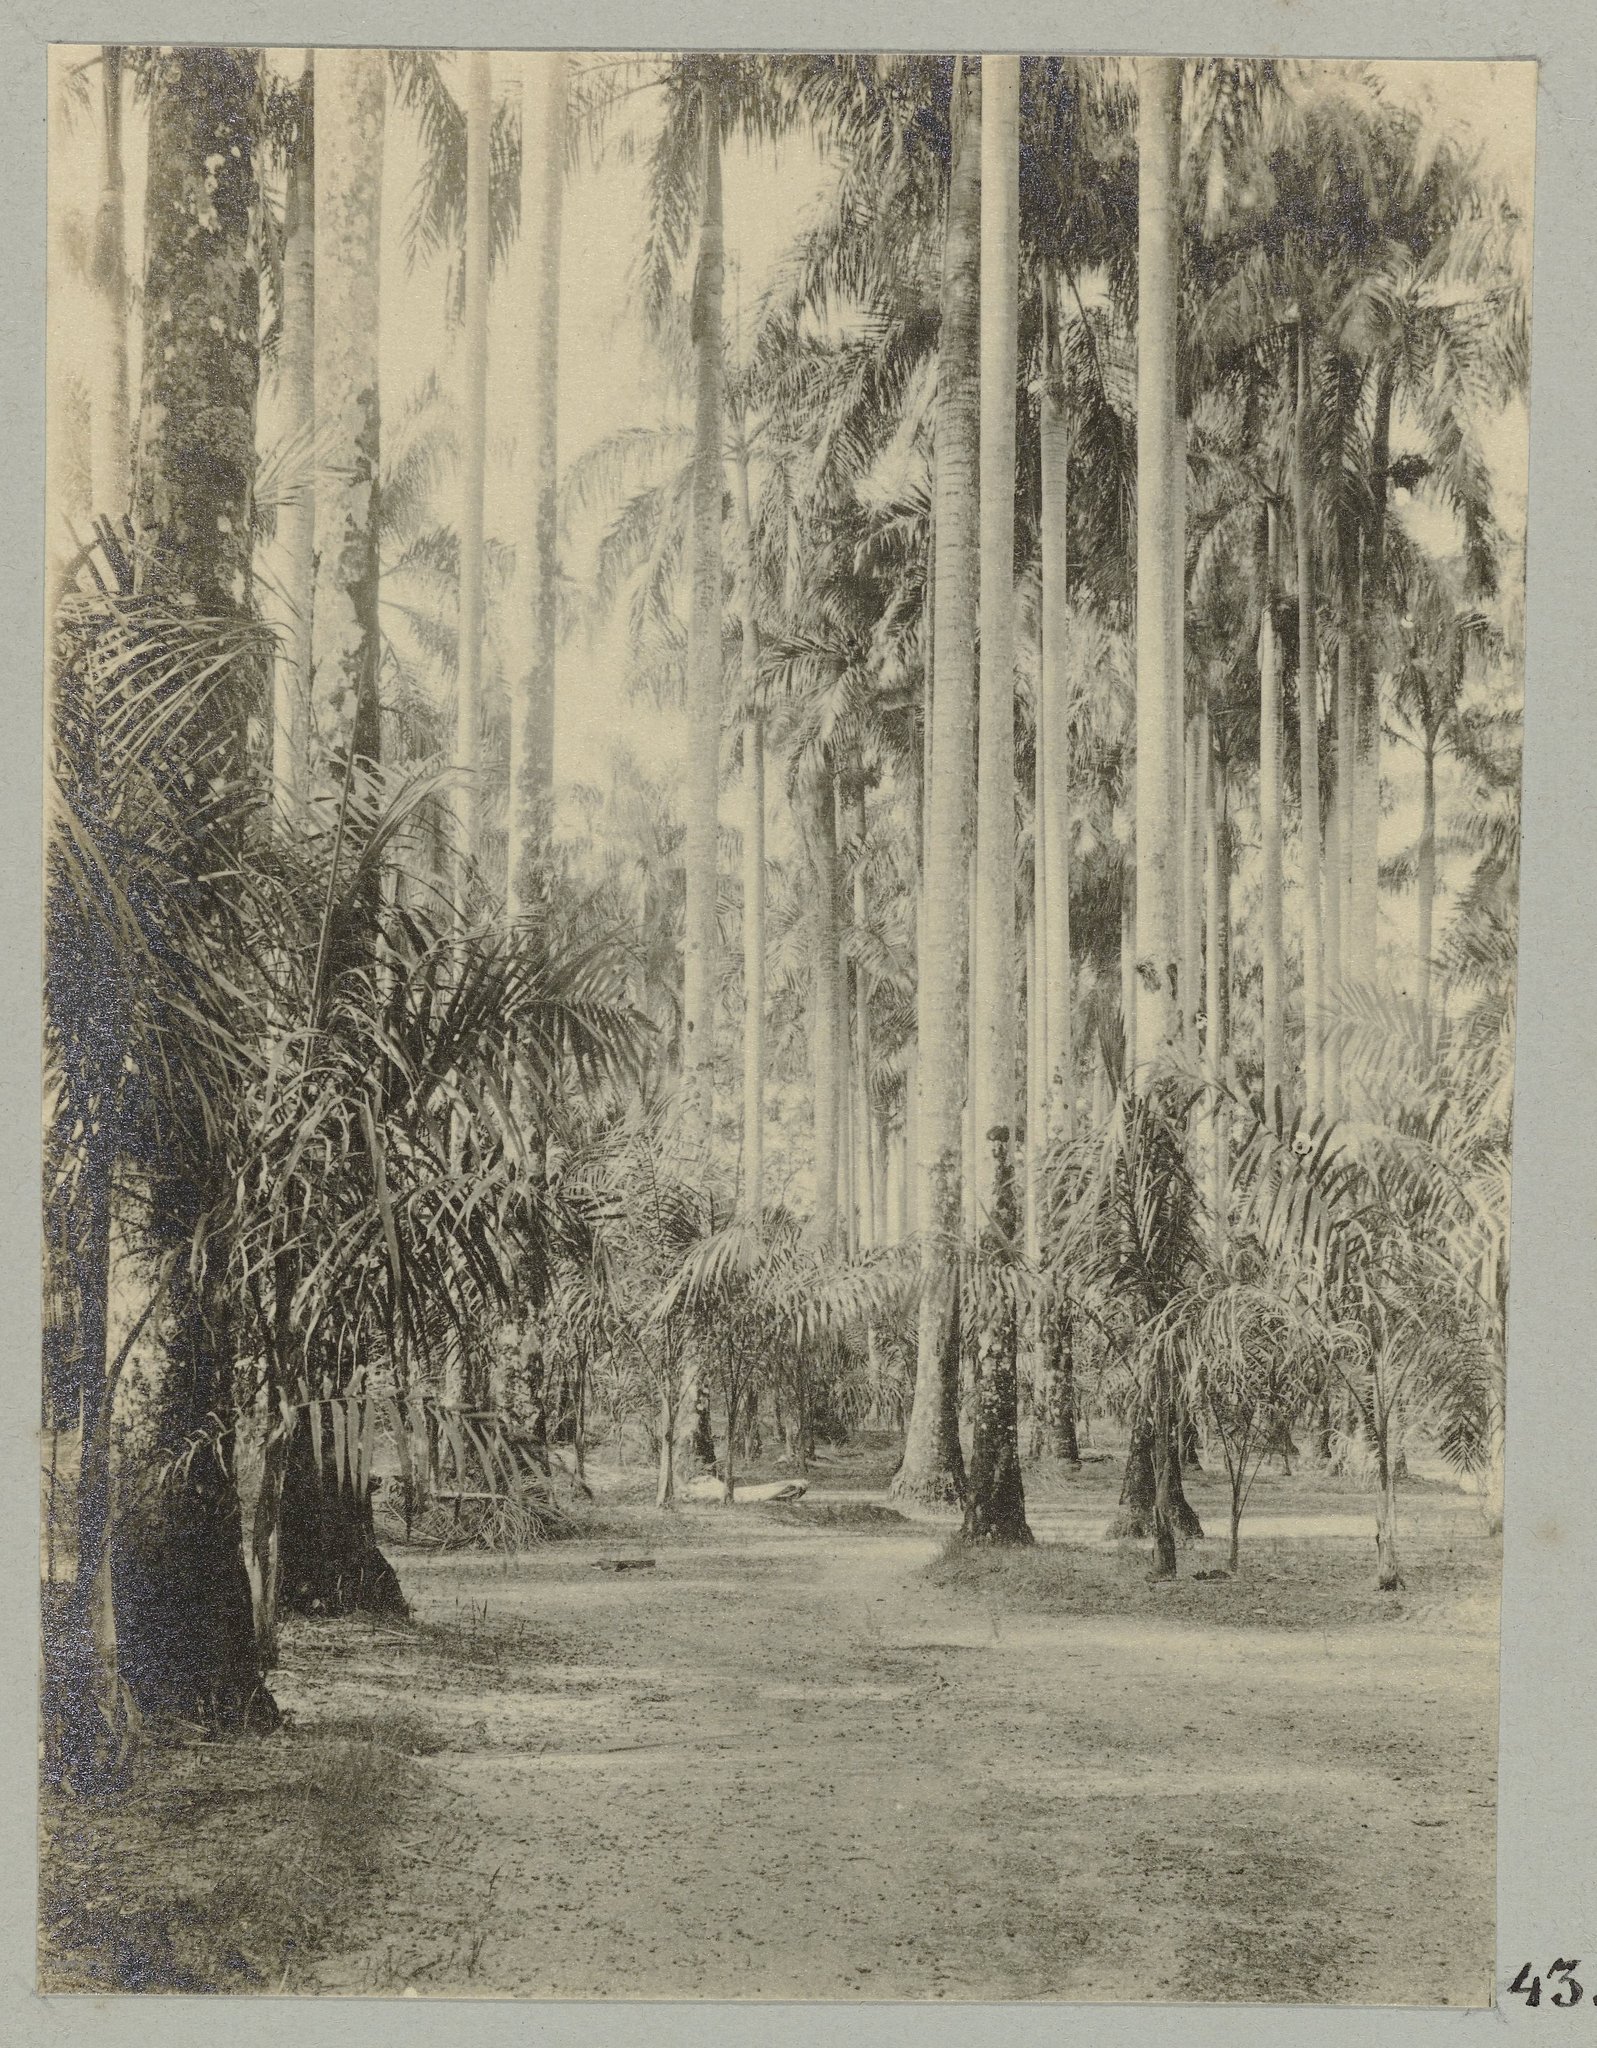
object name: photograph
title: Palmentuin, Paramaribo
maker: hendrik doijer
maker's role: engineer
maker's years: 1863-1925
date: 1903-1910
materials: photographic support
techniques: gelatin silver print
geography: suriname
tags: suriname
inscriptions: inscription: ‘45. / Palmentuin, Paramaribo’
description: Hoge bomen in de Palmentuin te Paramaribo, aan het eind een bruggetje waarop een jongen staat. Onderdeel van het fotoalbum Souvenir de Voyage (deel 2), over het leven van de familie Doijer in en rond de plantage Ma Retraite in Suriname in de jaren 1903-1910.